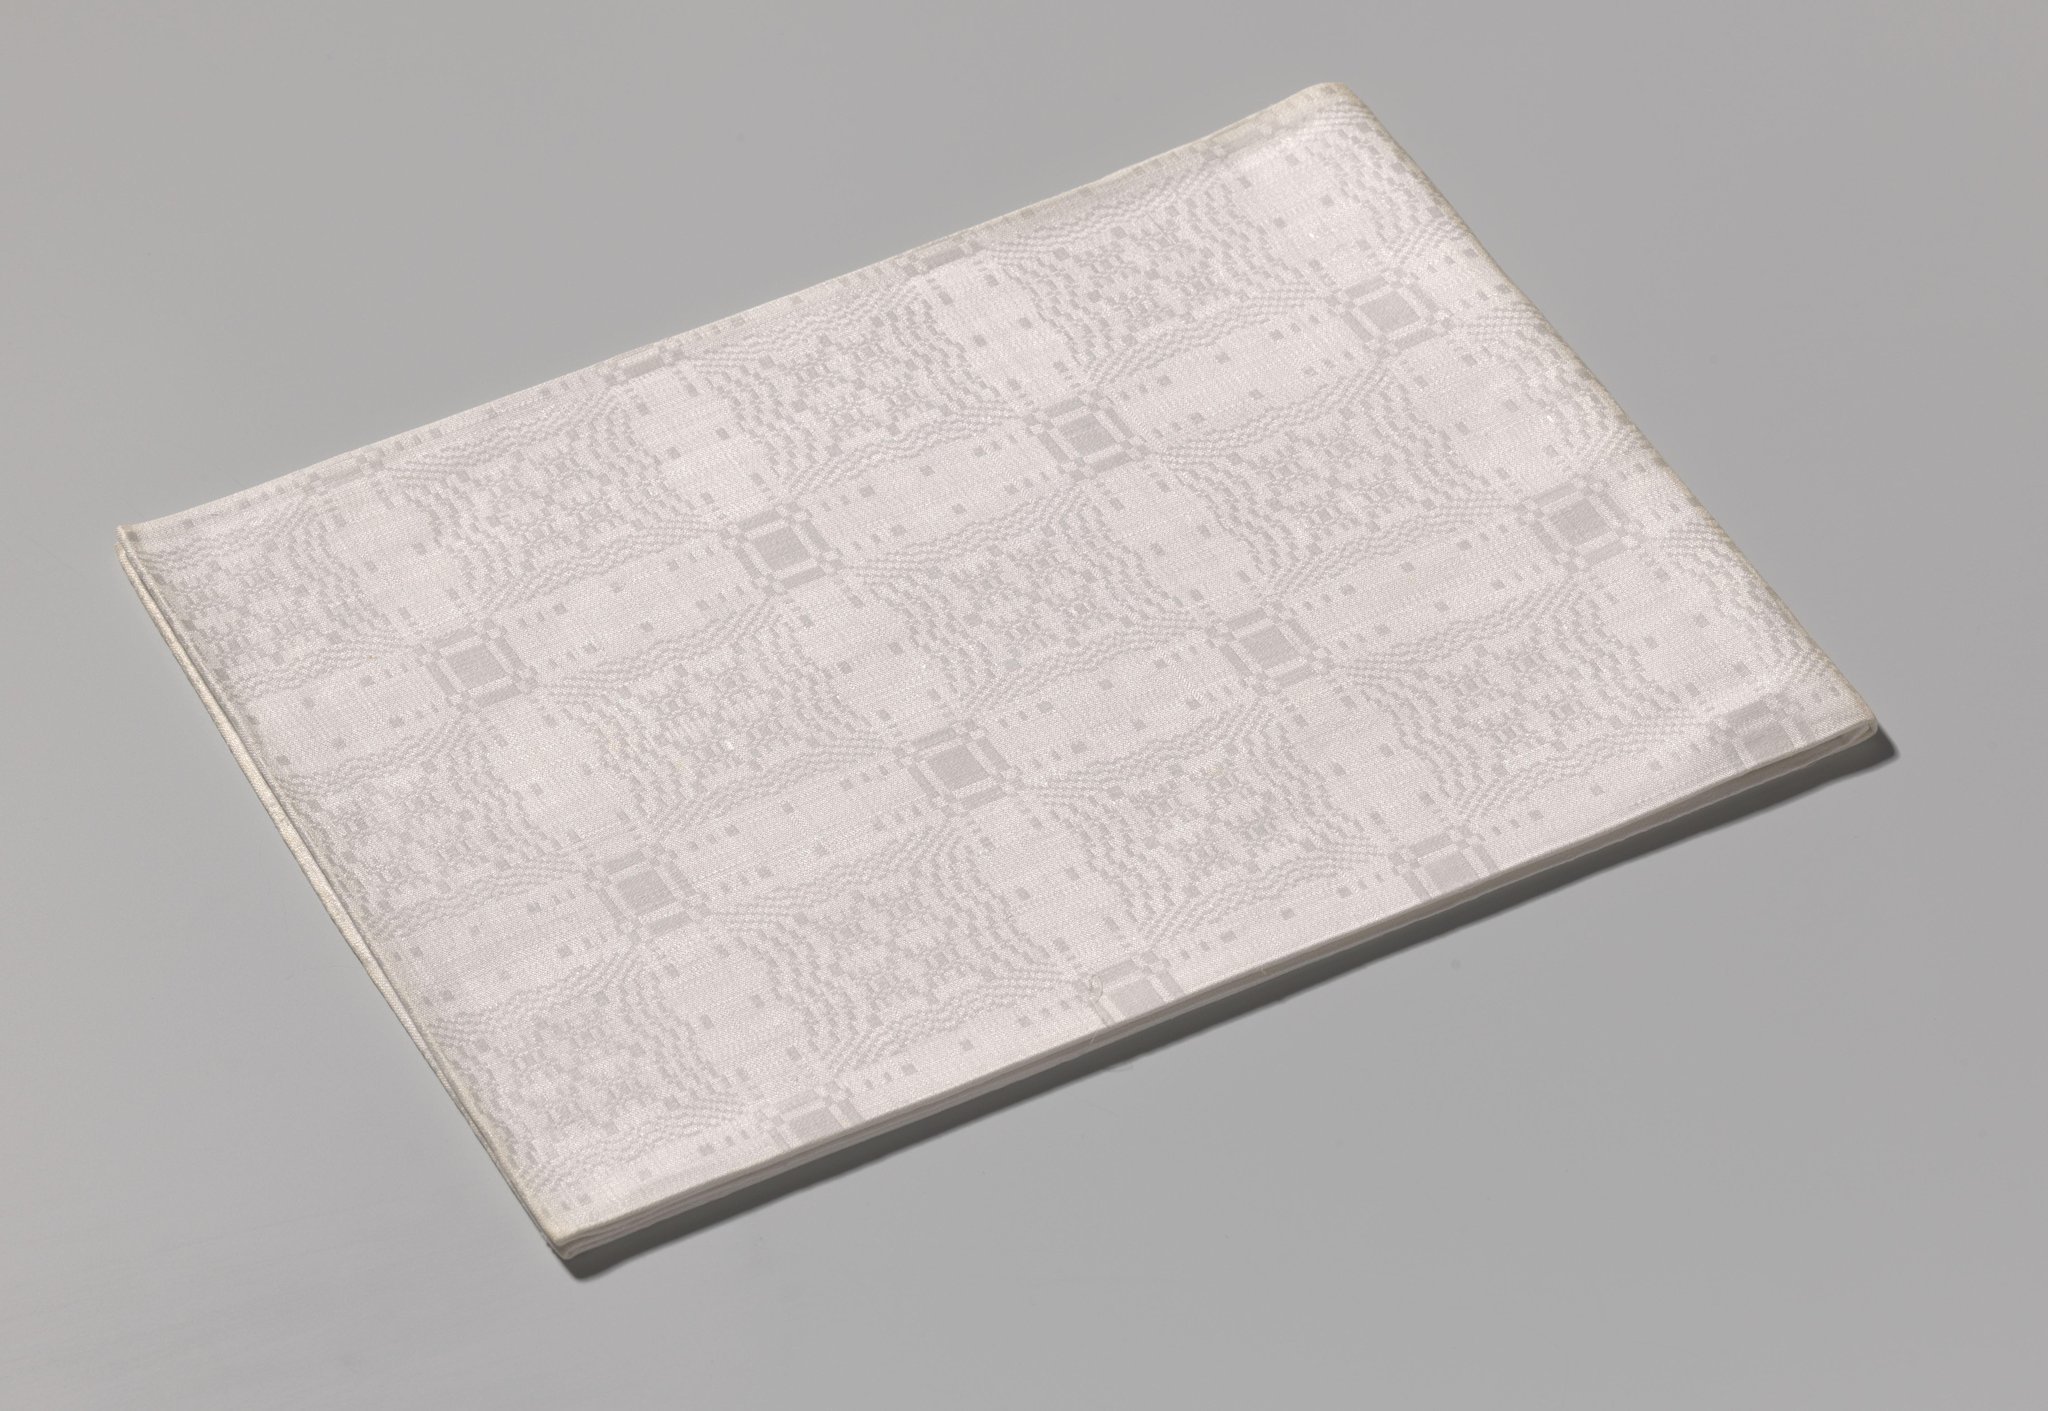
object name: napkin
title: Servet van linnen met pellenpatroon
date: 1400-1950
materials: linen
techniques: peeled fabric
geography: northern netherlands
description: Wit linnendamasten servet met pellenpatroon, merk kroon IS en 96.